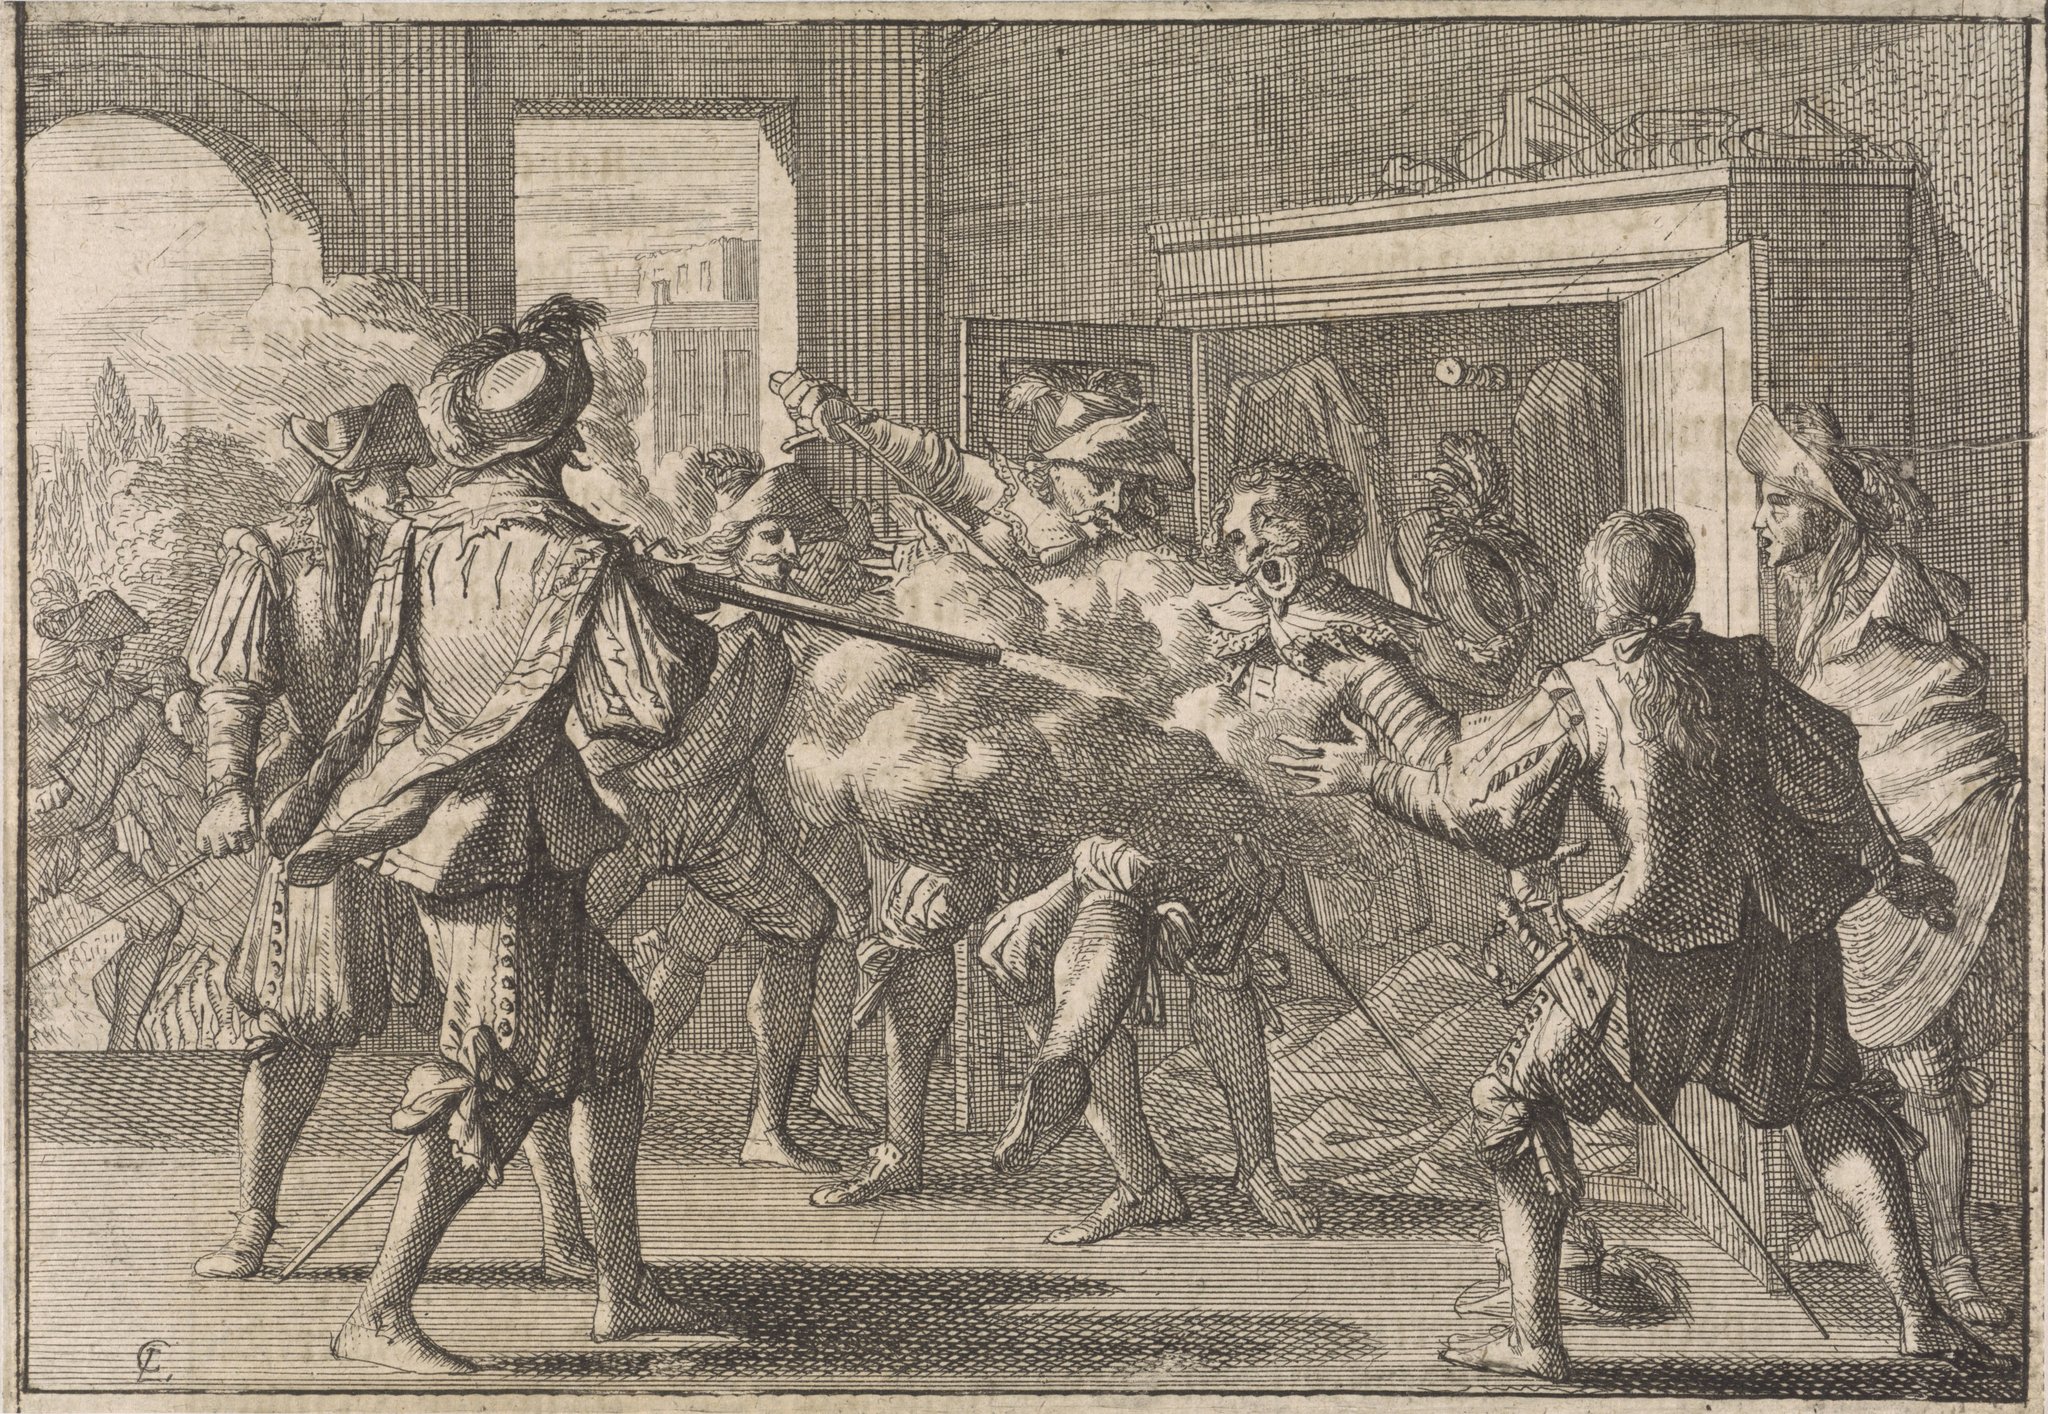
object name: book illustration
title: Miguel de Vasconcelos wordt ontdekt in een kast en vermoord door woedende Portugezen, 1640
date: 1701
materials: paper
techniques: etching, letterpress printing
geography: frankfurt am main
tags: violent death by firearms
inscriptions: collector's mark: Lugt 2228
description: Boekillustratie voor Hiob Ludolff. Allgemeine Schau-Bühne der Welt. Deel II. Frankfurt am Main: Johann David Zunnern, 1701, p. 801.